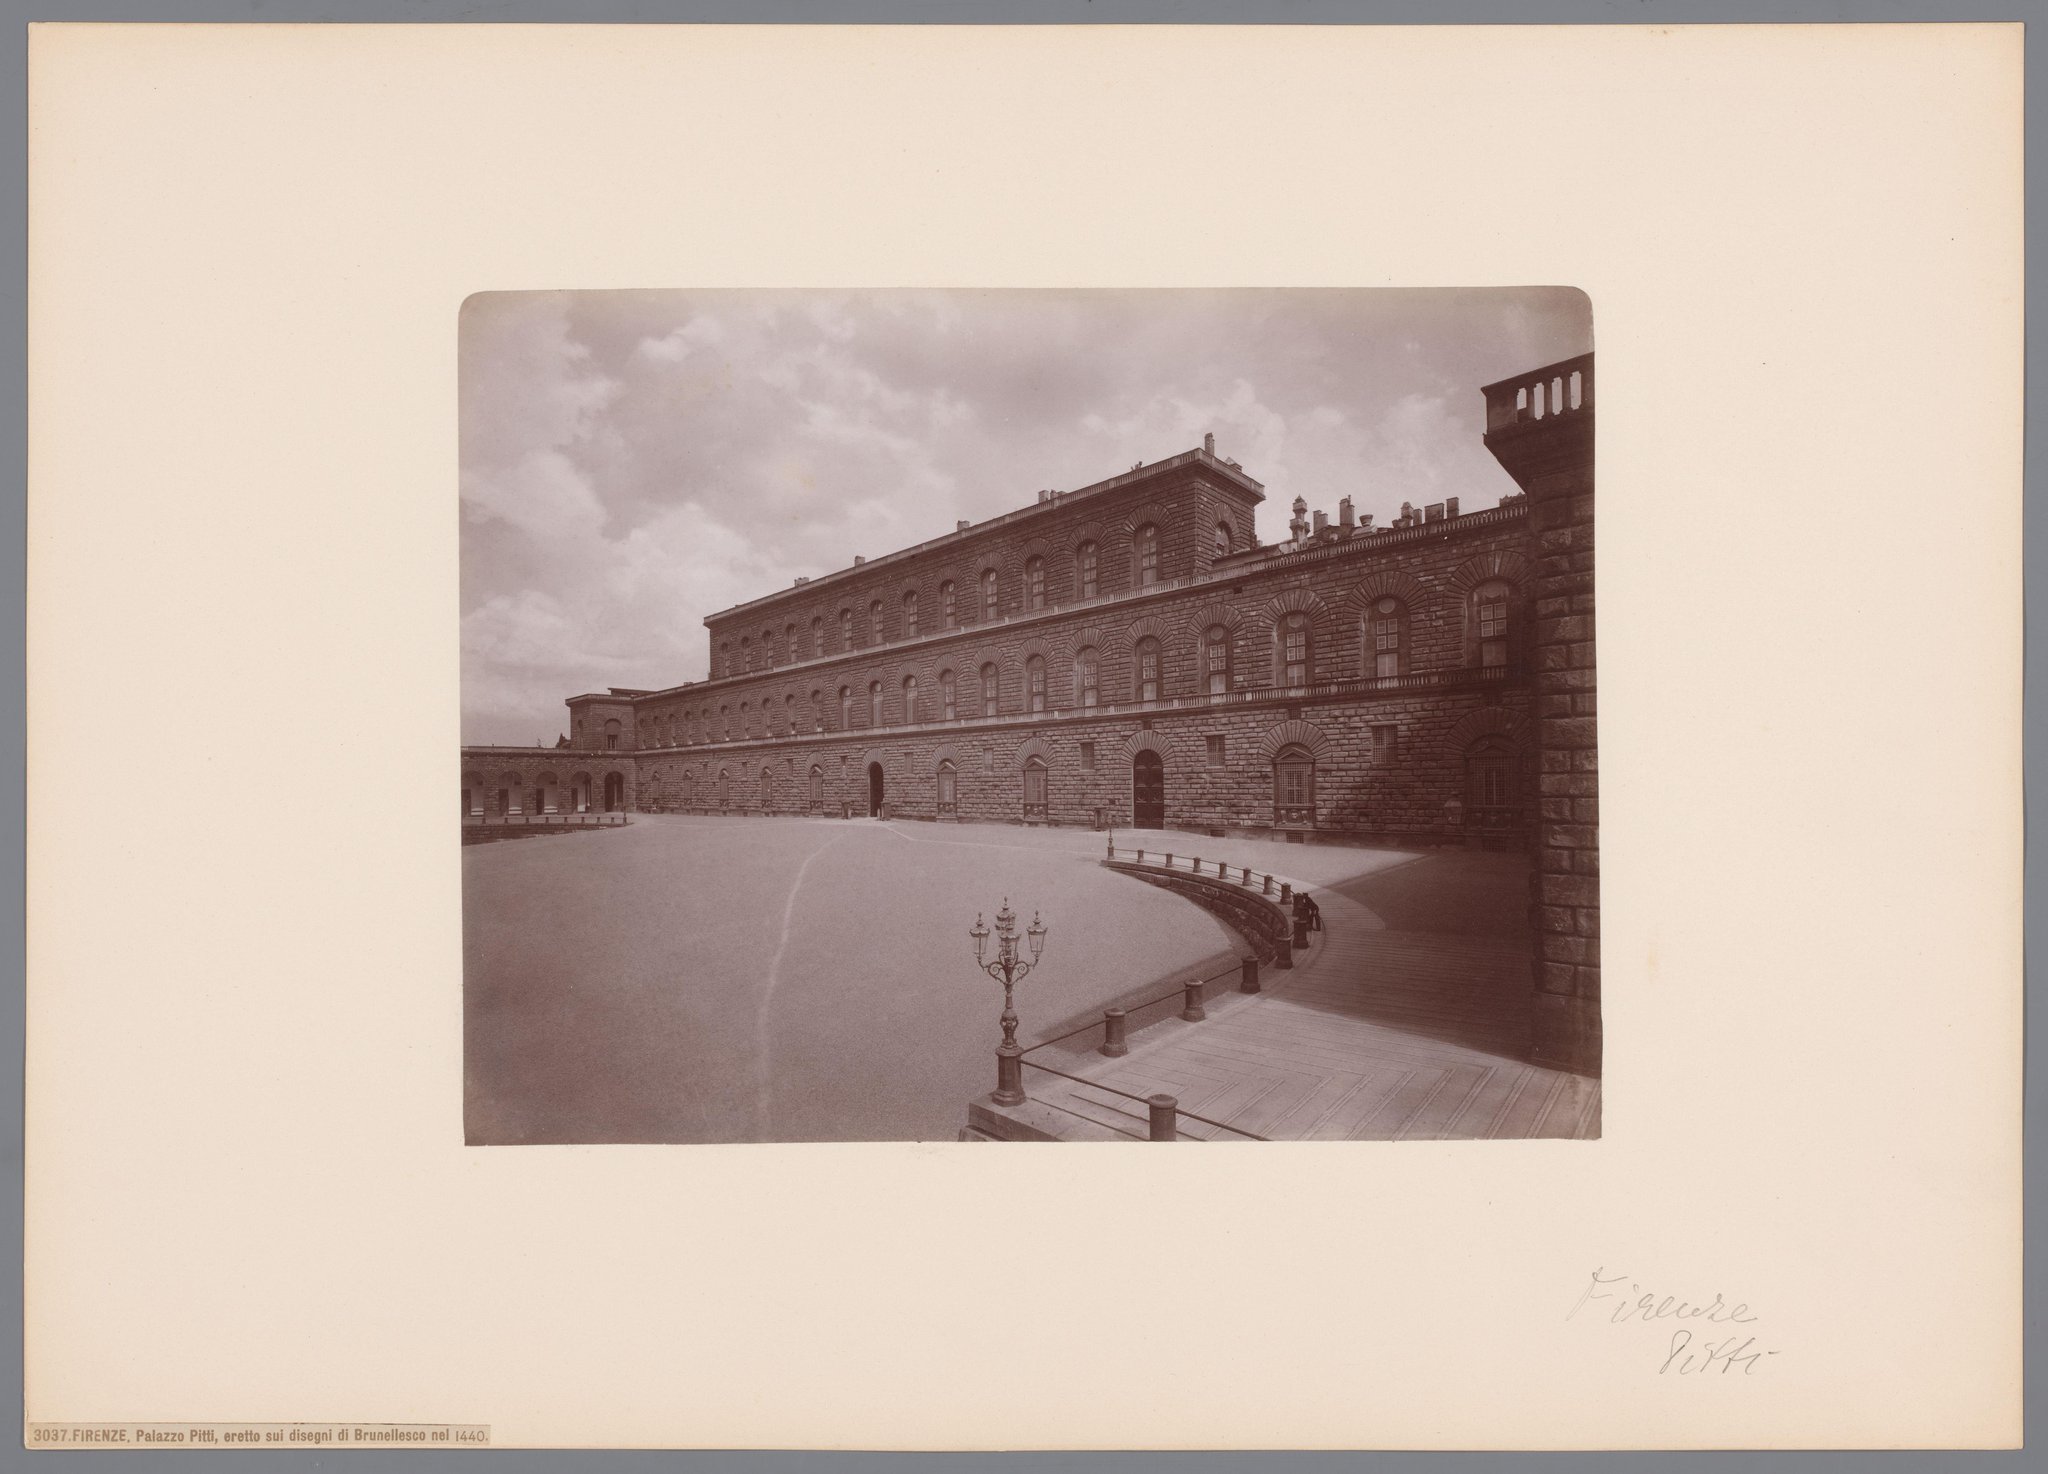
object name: photograph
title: Palazzo Pitti, eretto sui disegni di Brunellesco nel 1440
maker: giacomo brogi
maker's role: fotograaf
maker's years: 1822-1881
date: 1864-1881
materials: cardboard, paper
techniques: albumen print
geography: florence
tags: square, place, circus, etc., palace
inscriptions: inscription: ‘Firenze/ Pitti’, number: ‘3037.’, number: ‘36’